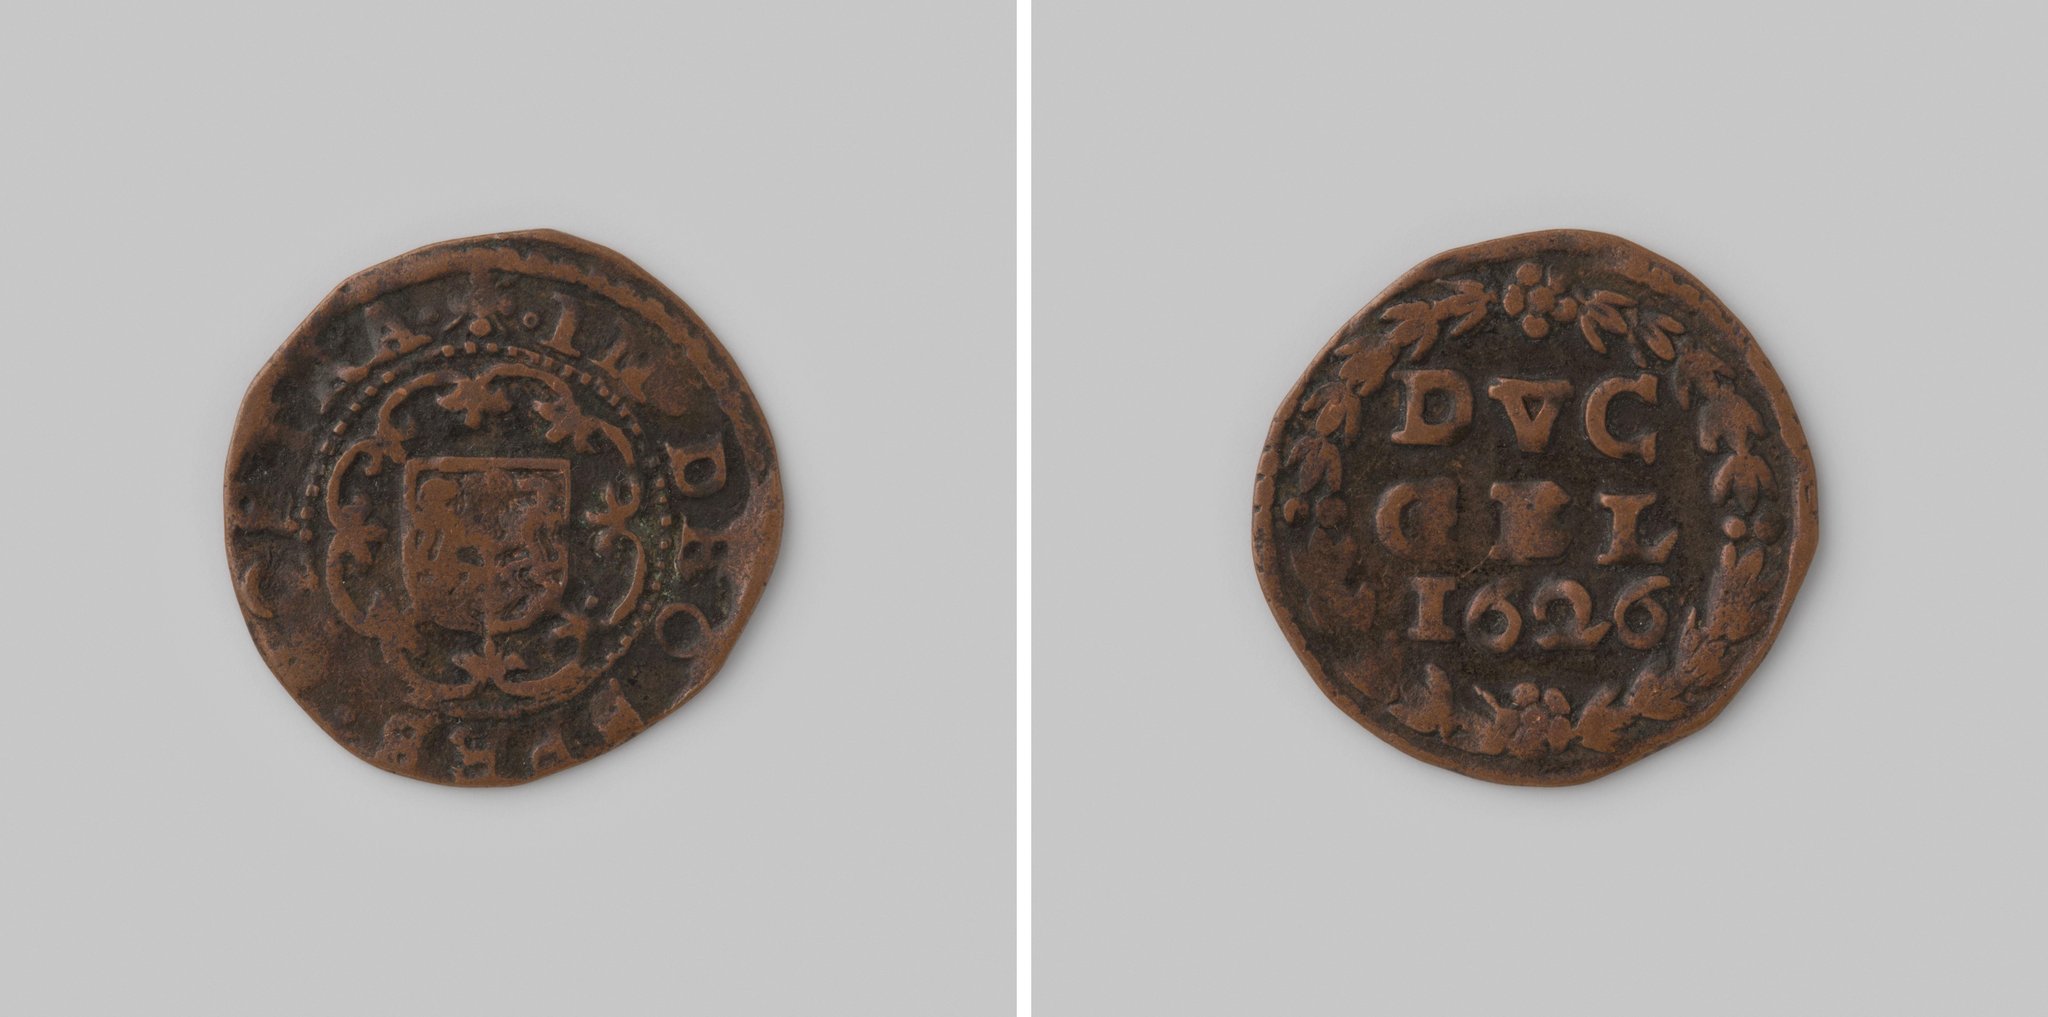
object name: coin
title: Gelderse duit, 1626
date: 1626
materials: copper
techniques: striking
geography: harderwijk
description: Koperen munt. Voorzijde: binnen lauwerkrans in twee regels DVC/GEL, daaronder jaartal. Keerzijde: binnen versierde veelpas Gelders wapenschild.